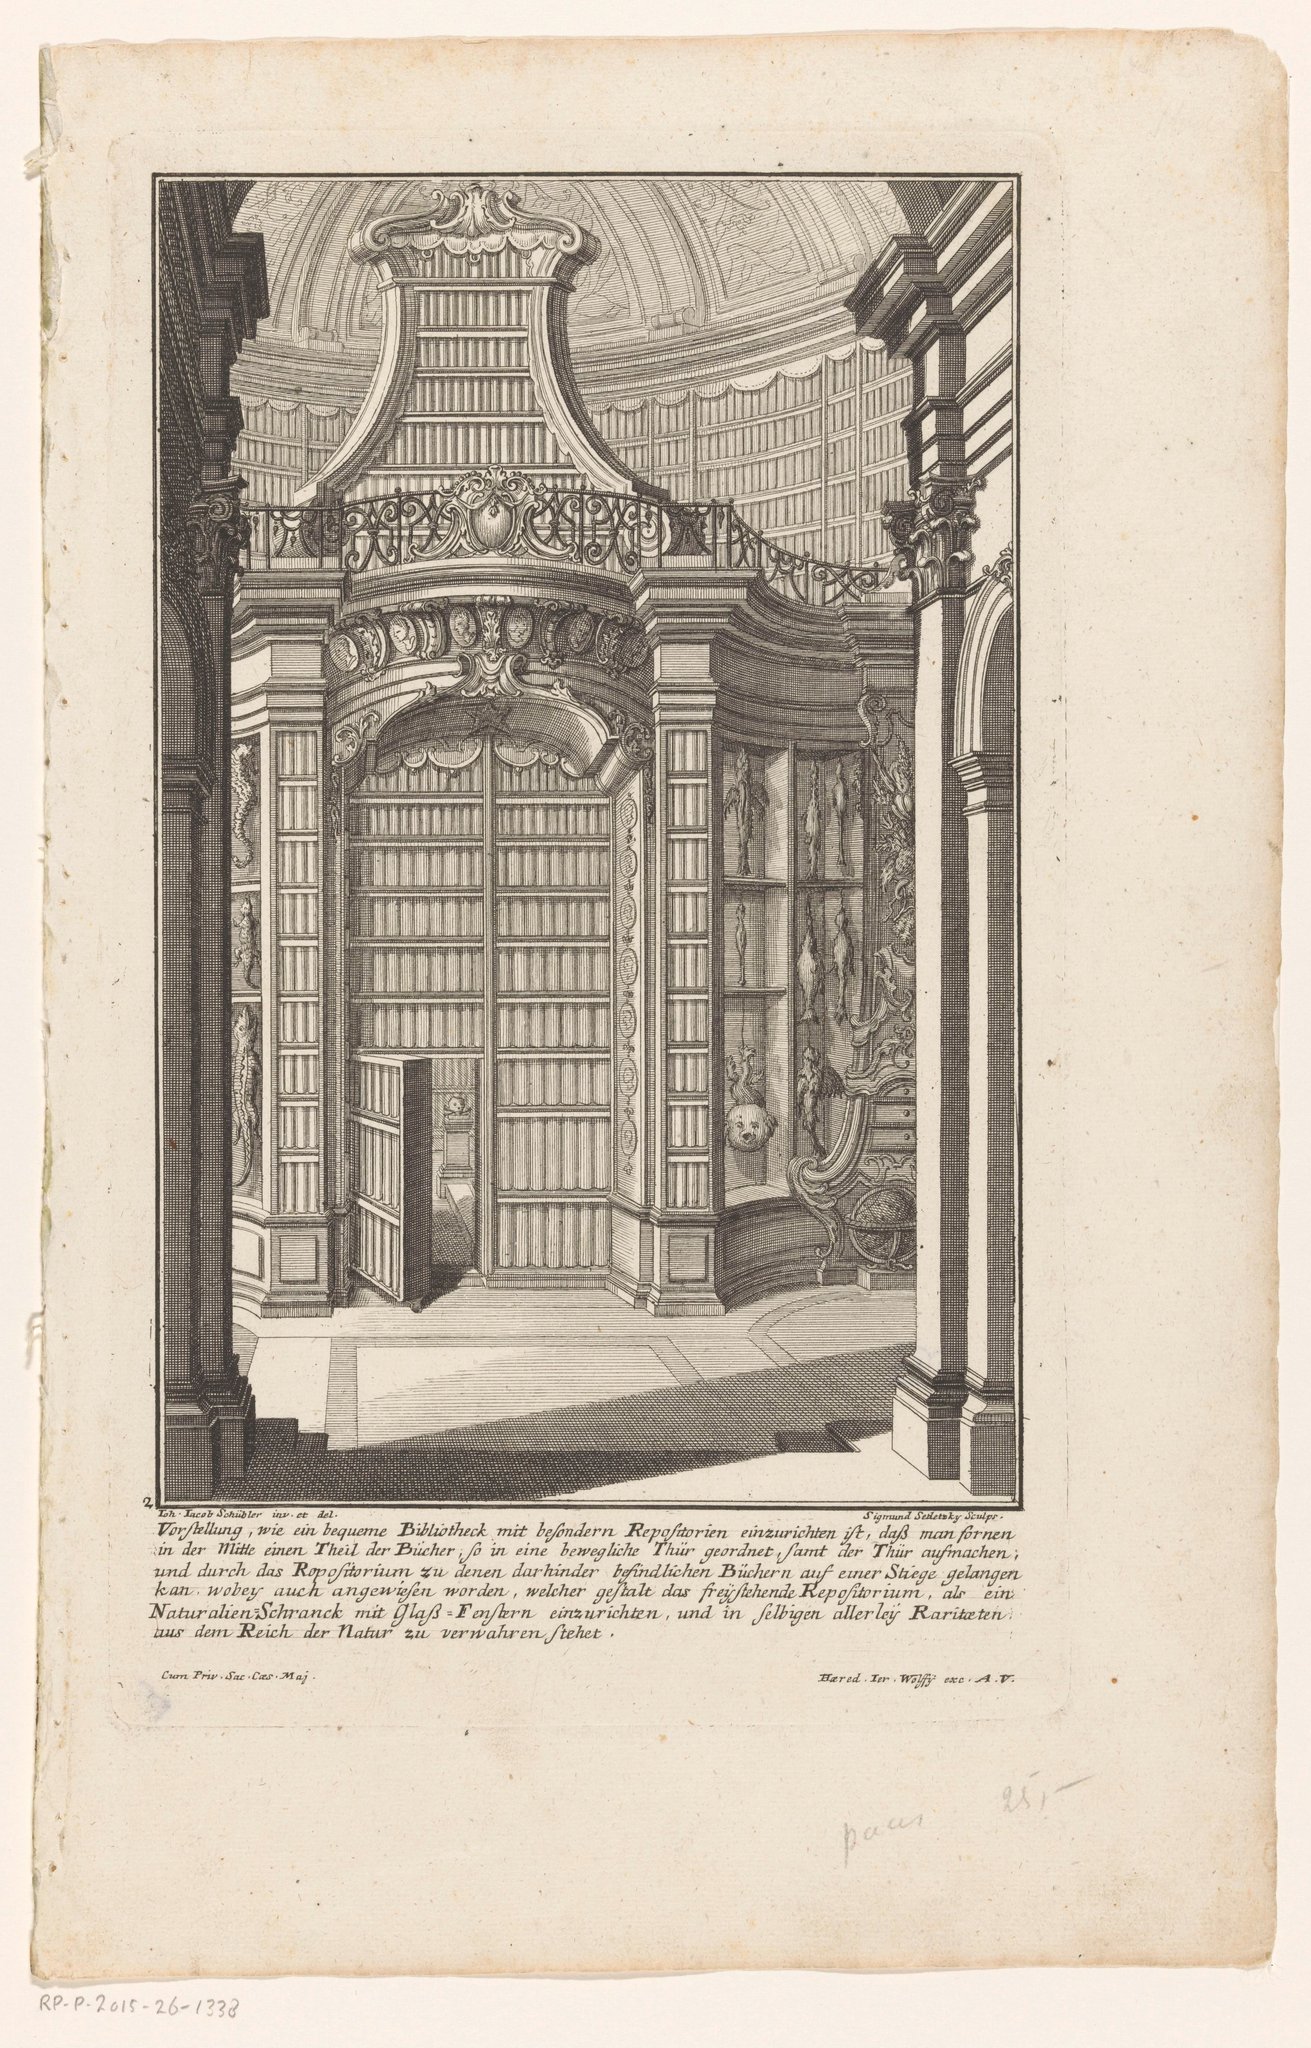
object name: print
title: Bibliotheek en rariteitenkabinet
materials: paper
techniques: etching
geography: augsburg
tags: bookshelves, 'kunstschrank', cabinet of curiosities, 'kunst- und wunderkammer', public library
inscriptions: collector's mark: Lugt 4780, collector's mark: Lugt 4779, collector's mark: Lugt 2228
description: Bibliotheek met een boekenkast als deur die leidt naar een verborgen vertrek. Rechts een rariteitenkabinet met gedroogde vissen hangend in nissen. In de ondermarge een zesregelige Duitse tekst.